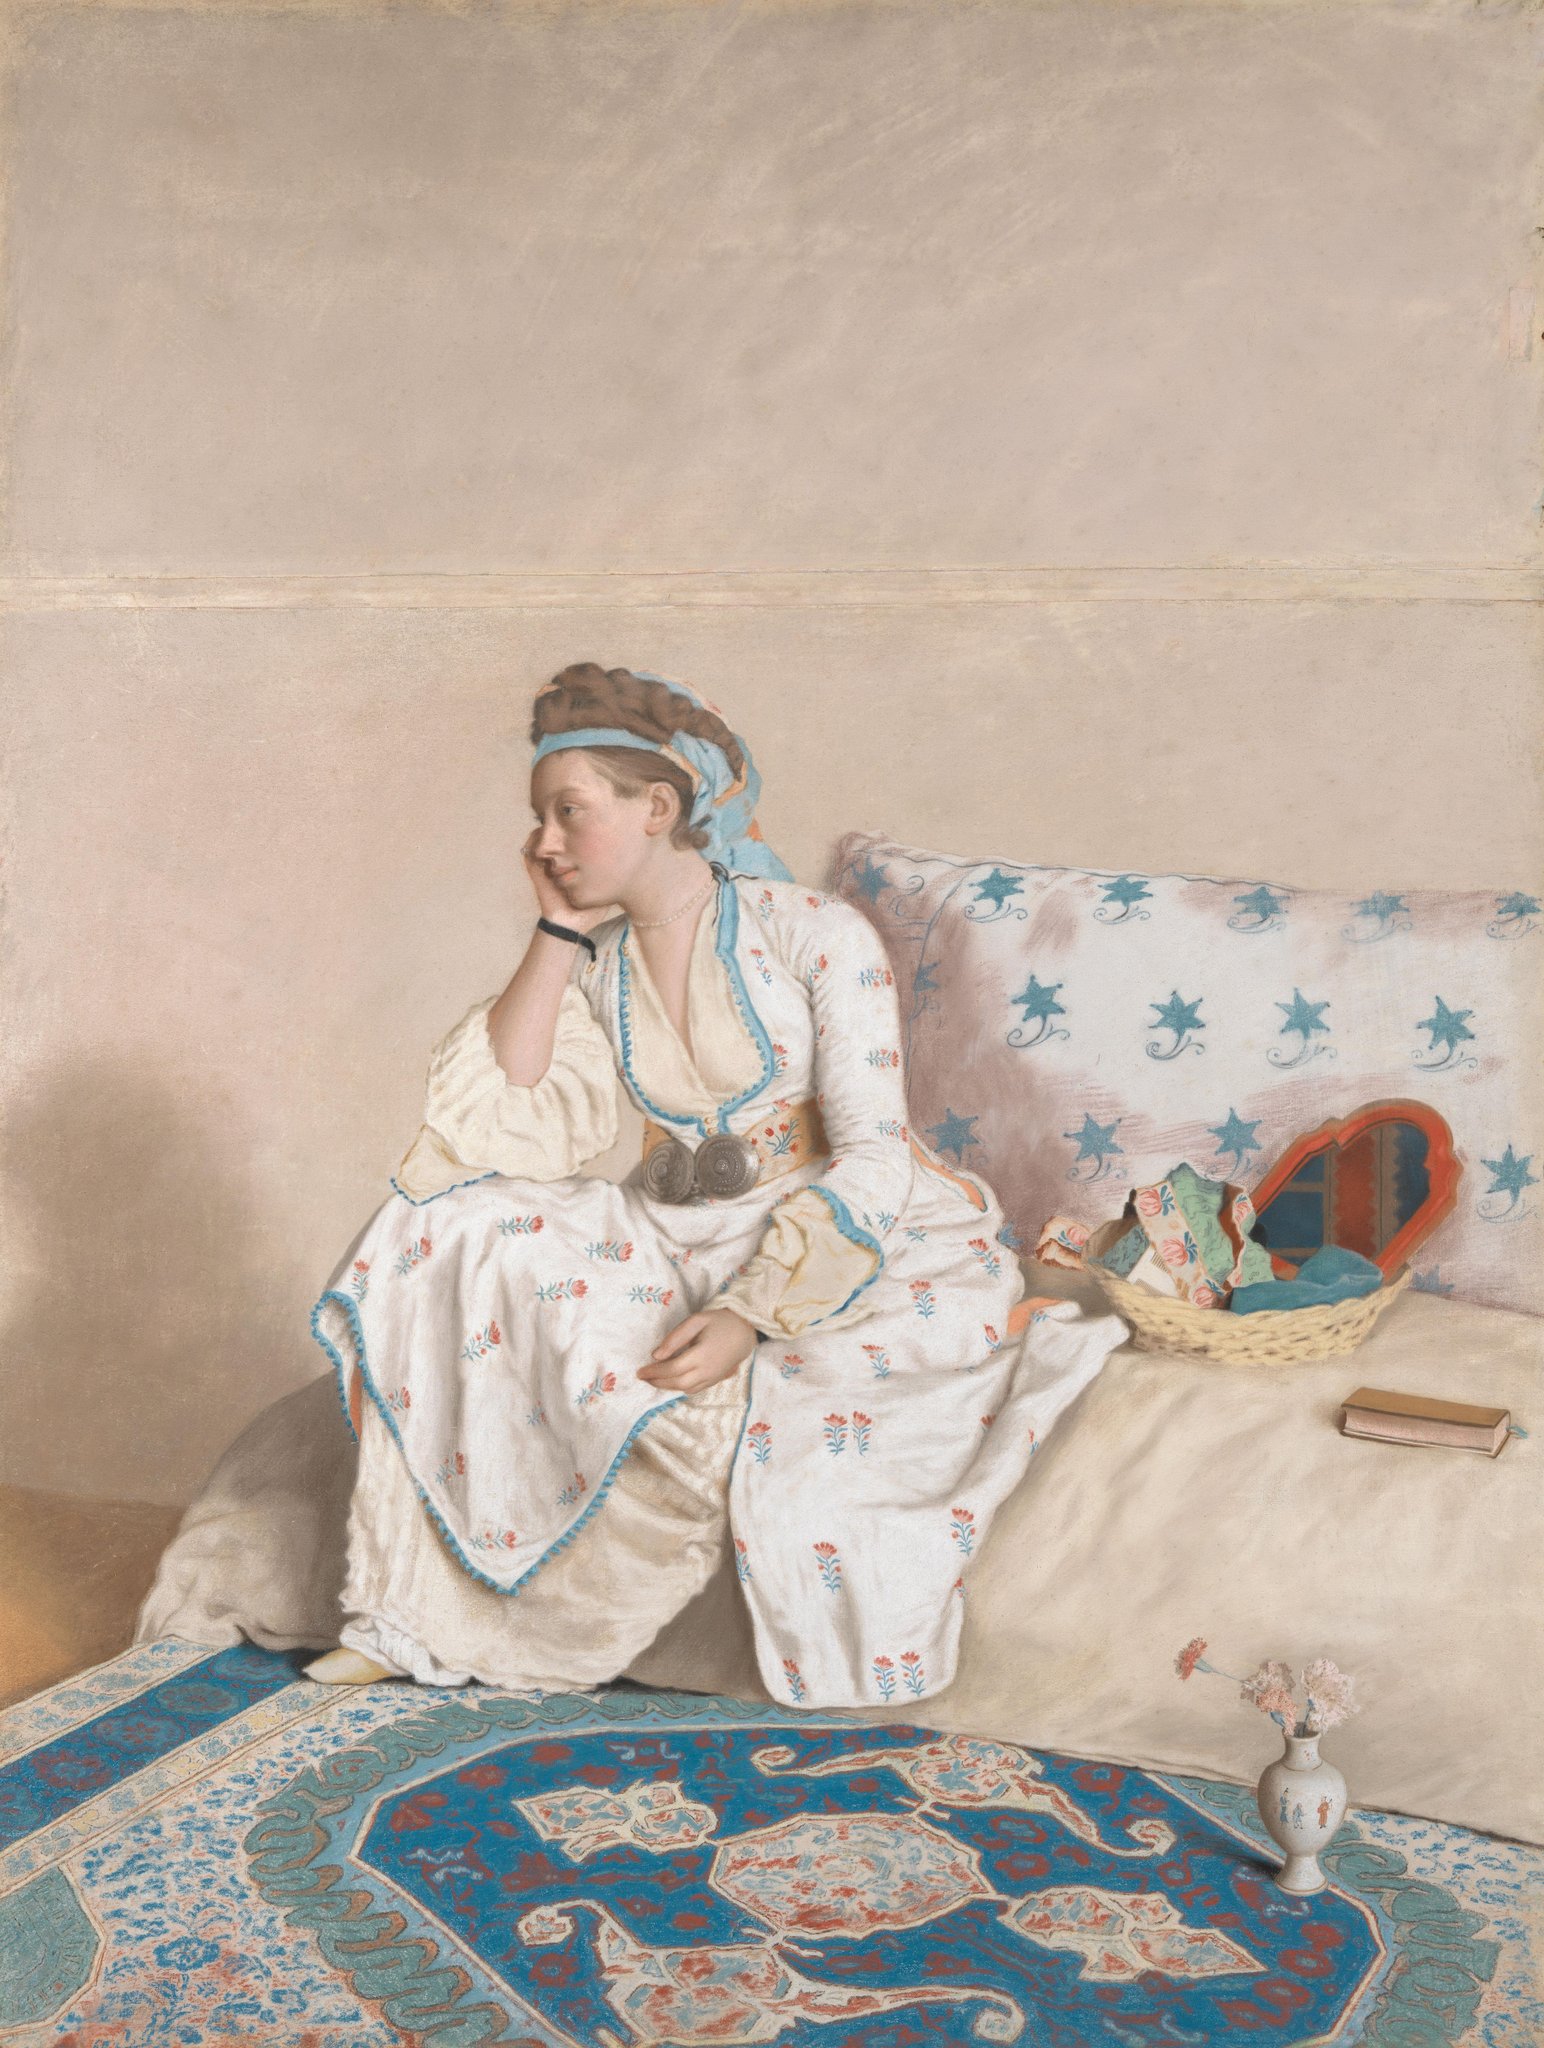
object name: pastel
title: Marie Fargues, the Painter’s Wife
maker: jean-etienne liotard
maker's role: painter, print maker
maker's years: 1702-1789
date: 1756-1758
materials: parchment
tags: historical persons - bb - woman, mirror, book, folk costume, regional costume, flowers in a vase, couch, sofa, settee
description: Liotard was already 54 when he married the 29-yearold Marie Fargues in Amsterdam in 1756. This extraordinary portrait – it is one of Liotard’s largest pastels and necessitated the use of two pieces of vellum – was probably done shortly following their wedding. Liotard chose a composition he had first used in a drawing made in Constantinople and had repeated several times in different contexts: it was, indeed, one of the most famous inventions of his persona as ‘Le peintre turc’.